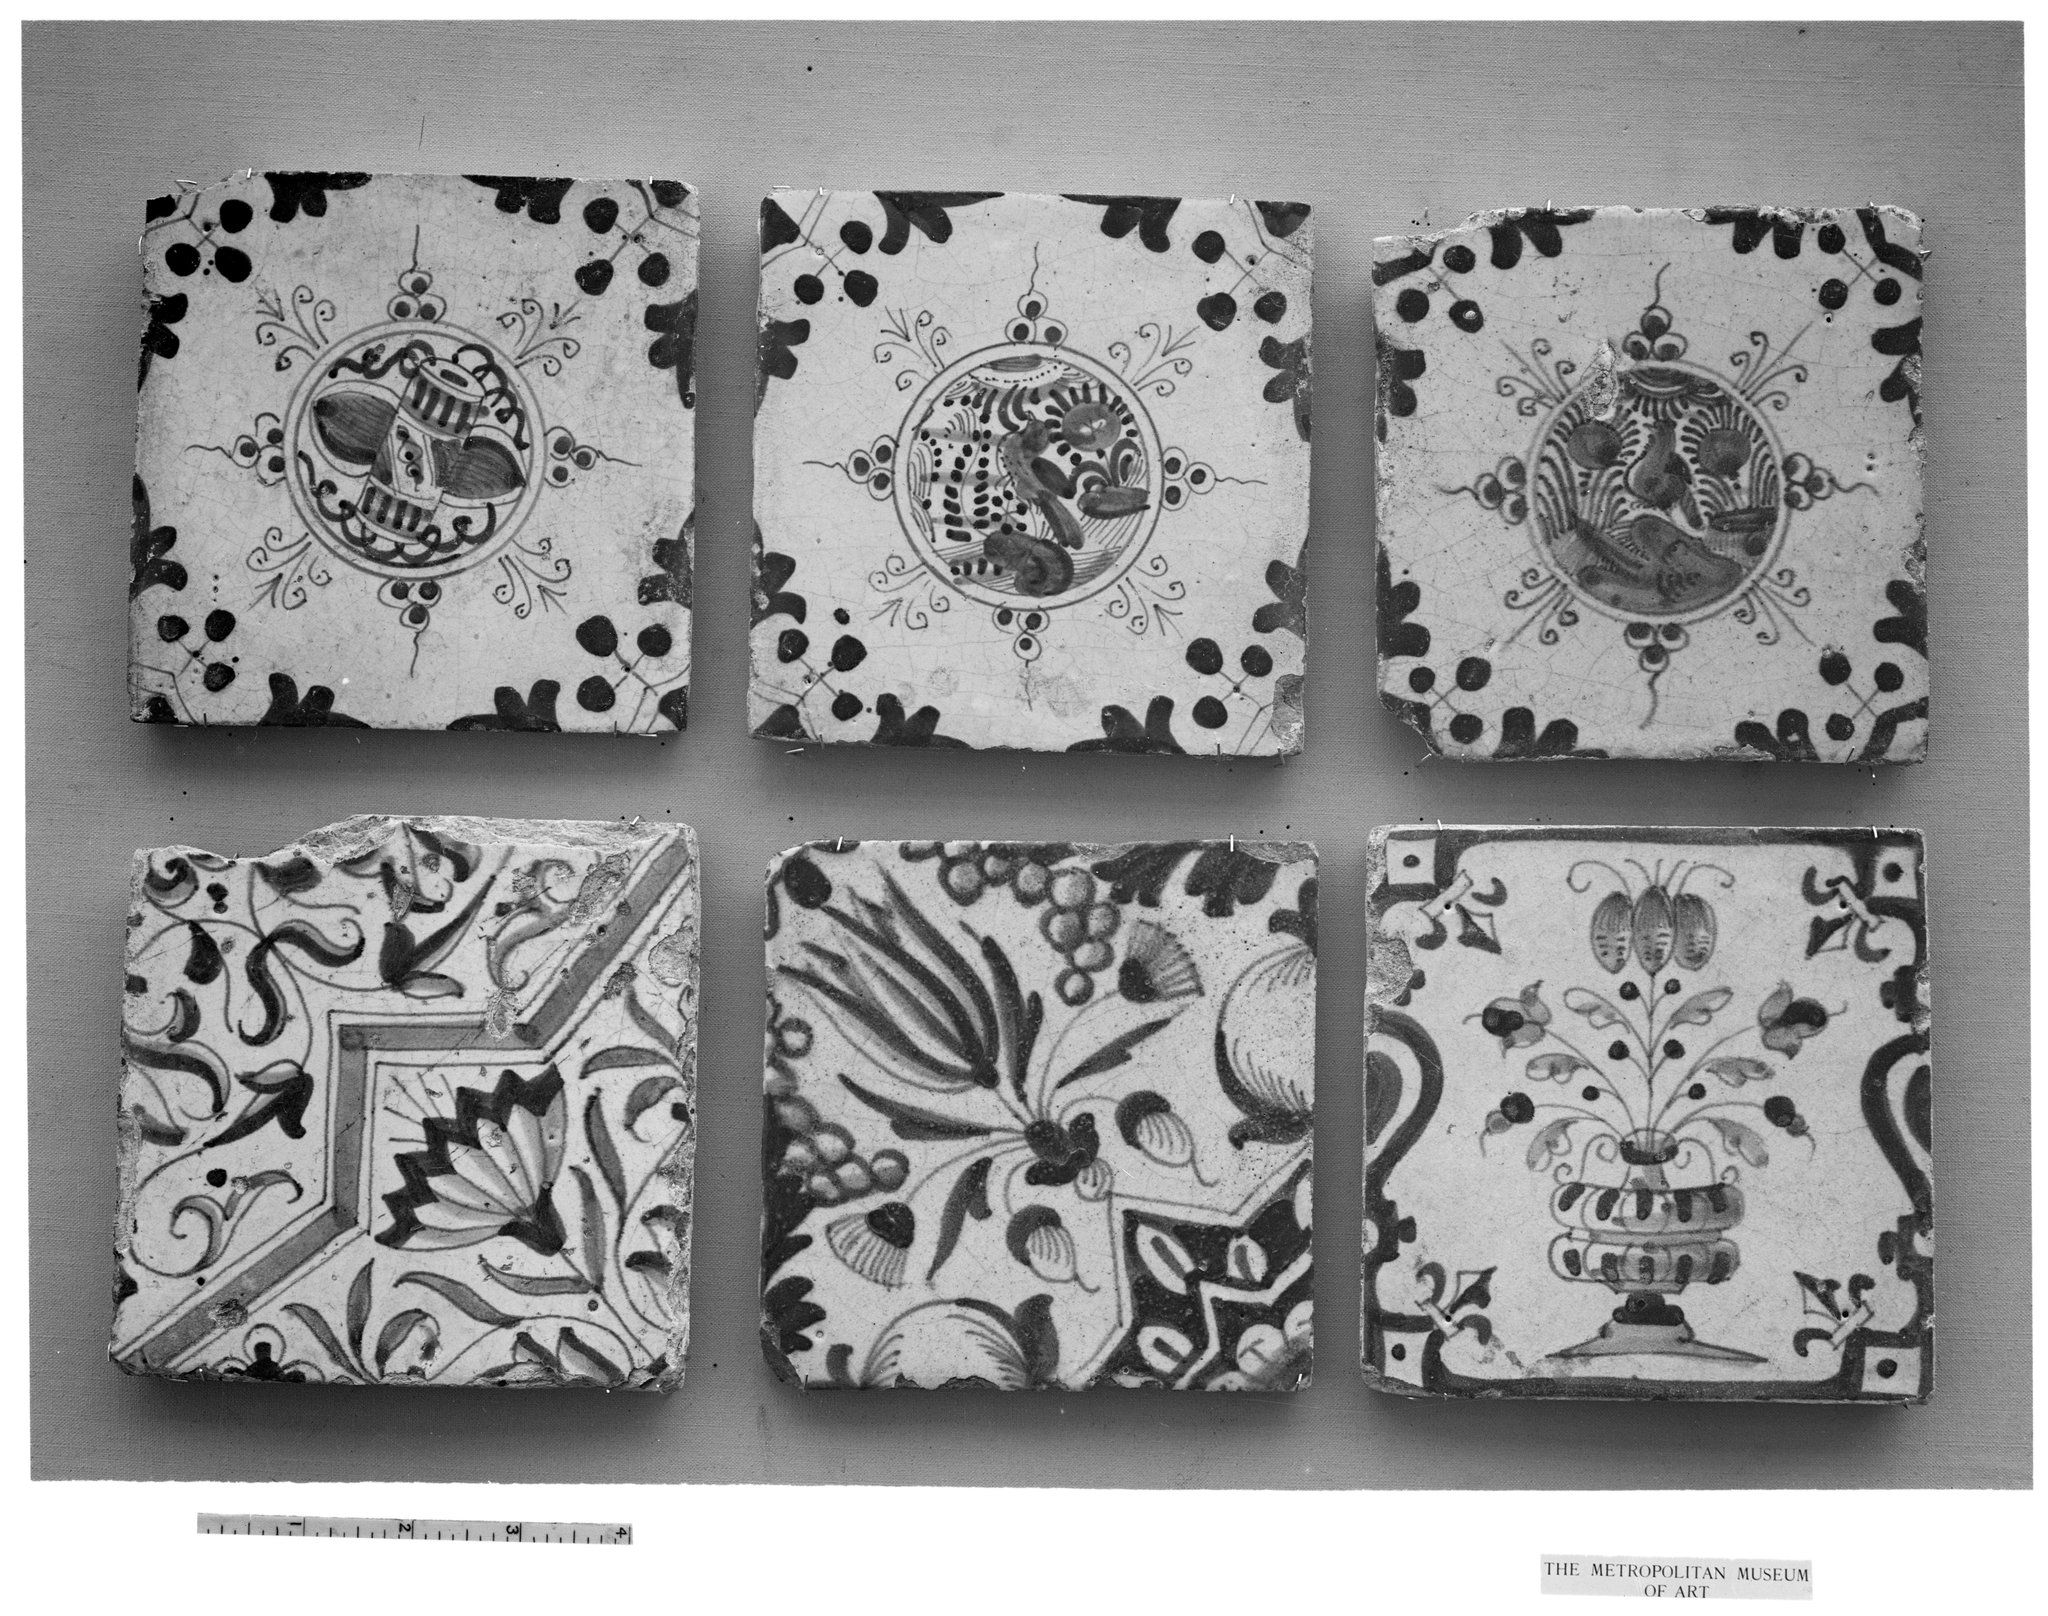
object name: tile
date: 1640-1660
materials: earthenware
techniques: glazing